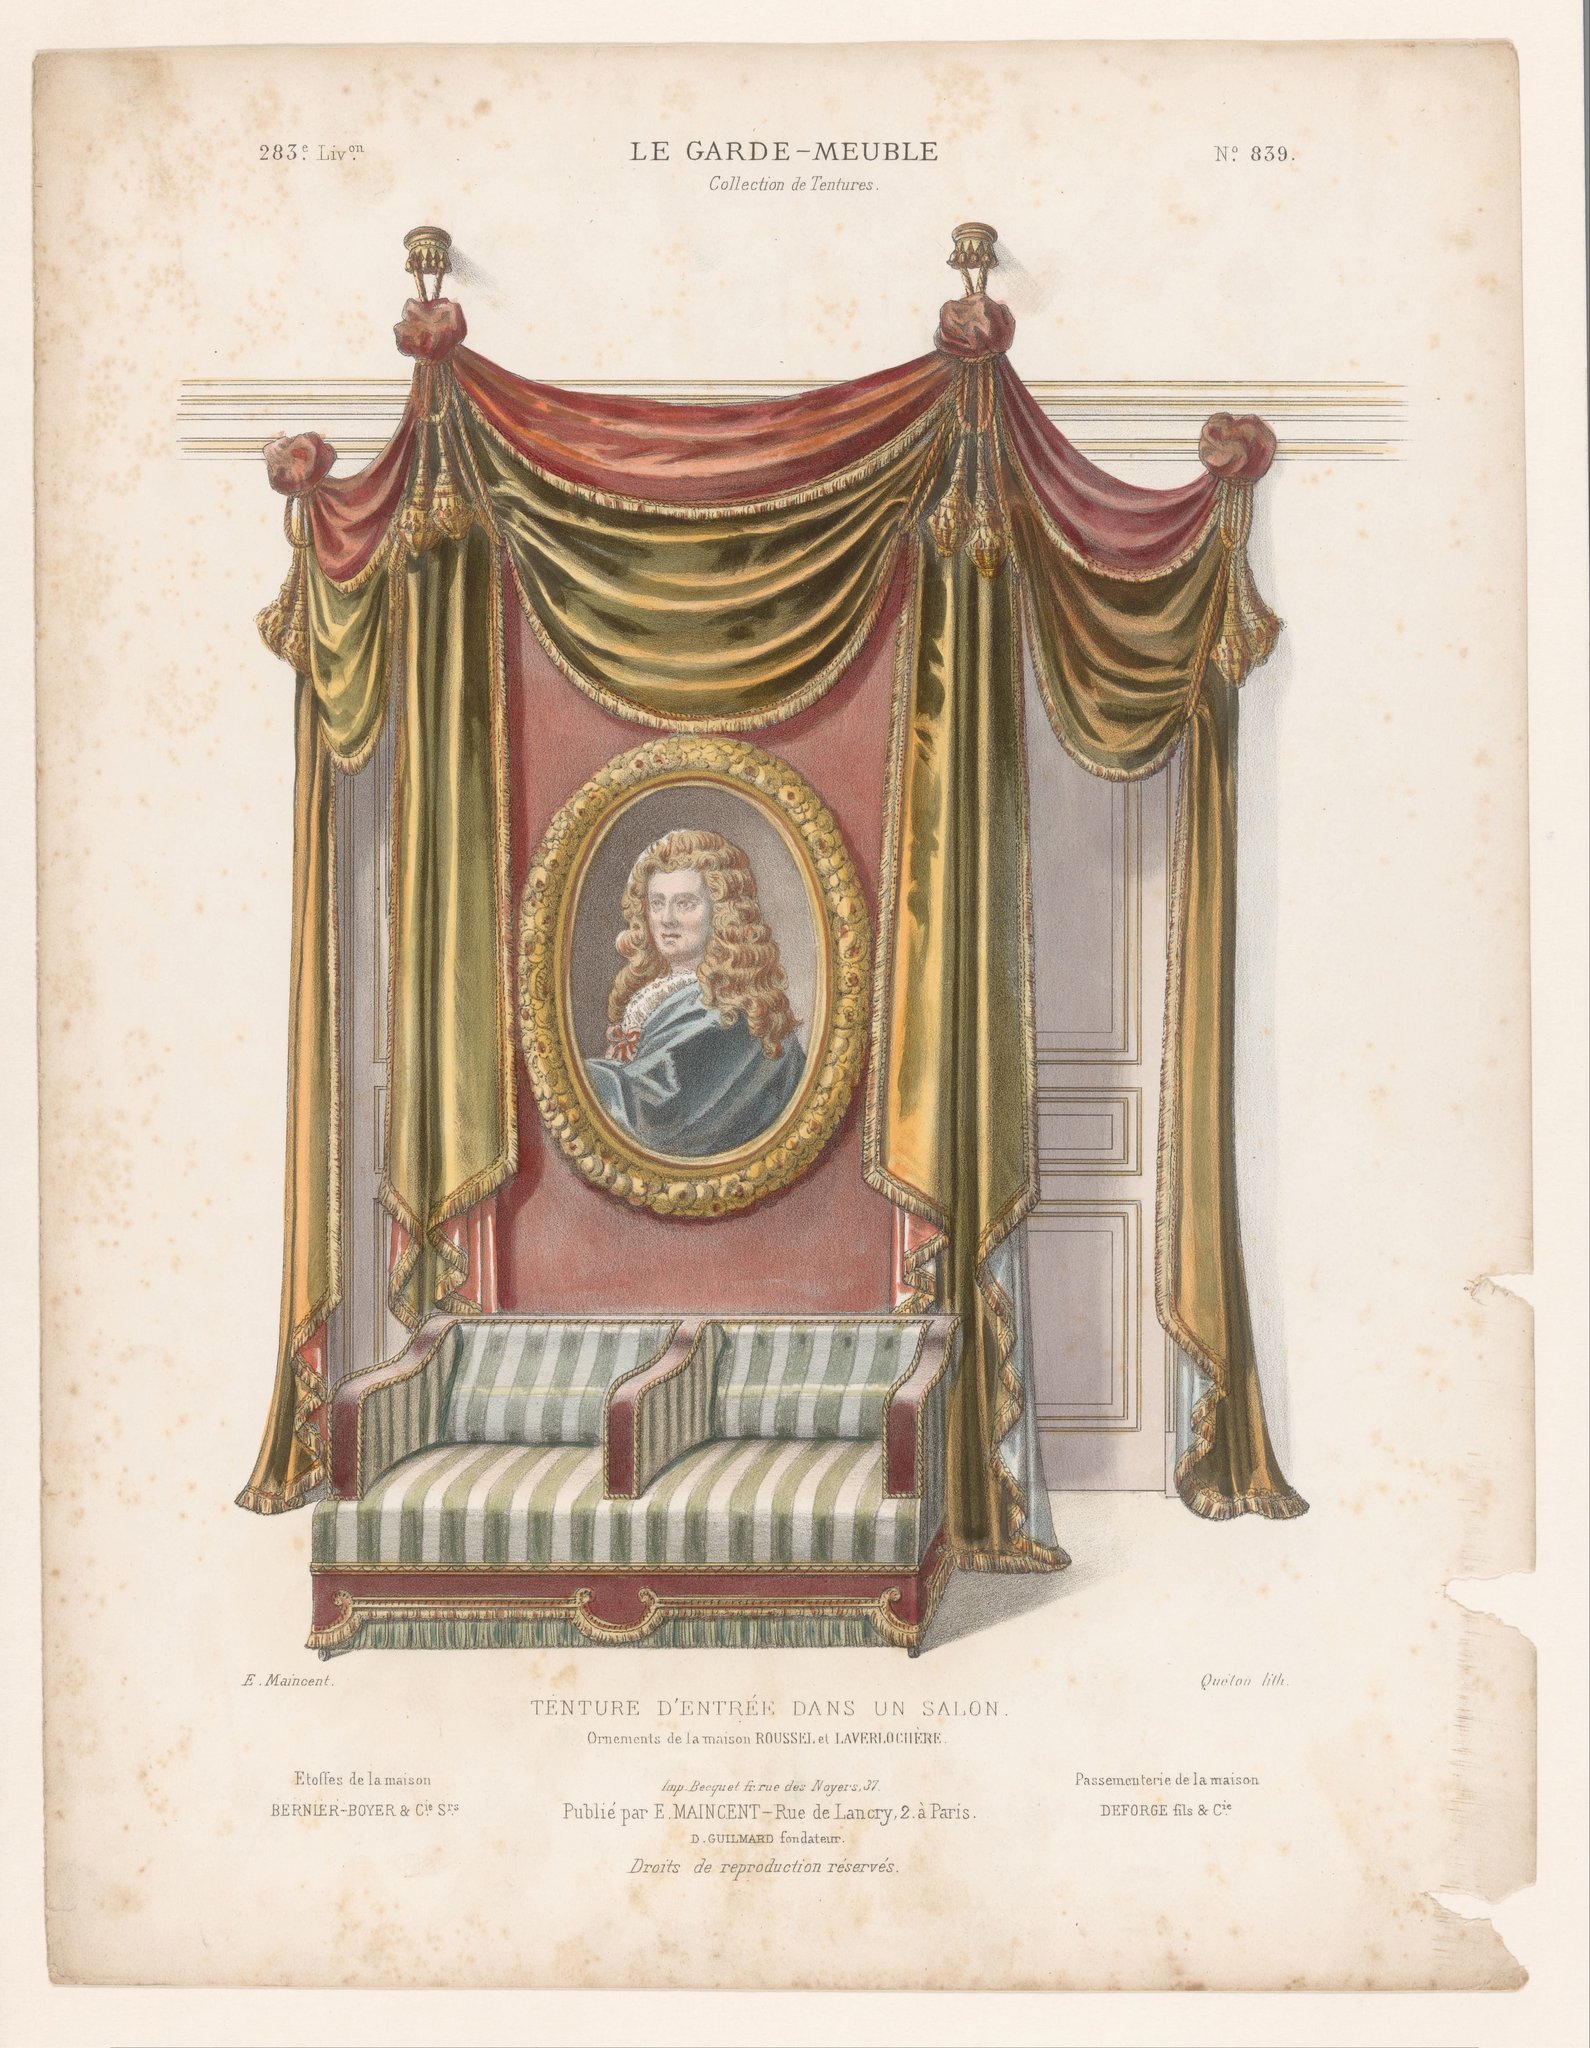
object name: print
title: Tenture d'entrée dans un salon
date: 1885-1895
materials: paper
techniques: hand coloring, lithograph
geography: paris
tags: window, hangings and drapery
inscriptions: : ‘Droits de reproduction réservés.’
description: Entree van een salon met gedrapeerde gordijnen. Prent uit 283e Livraison.